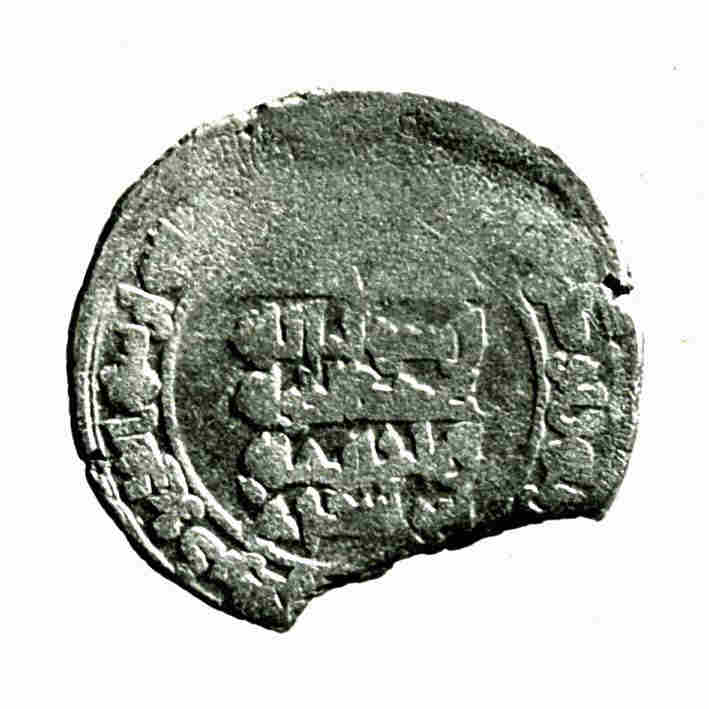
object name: coin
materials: silver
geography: arrajan?